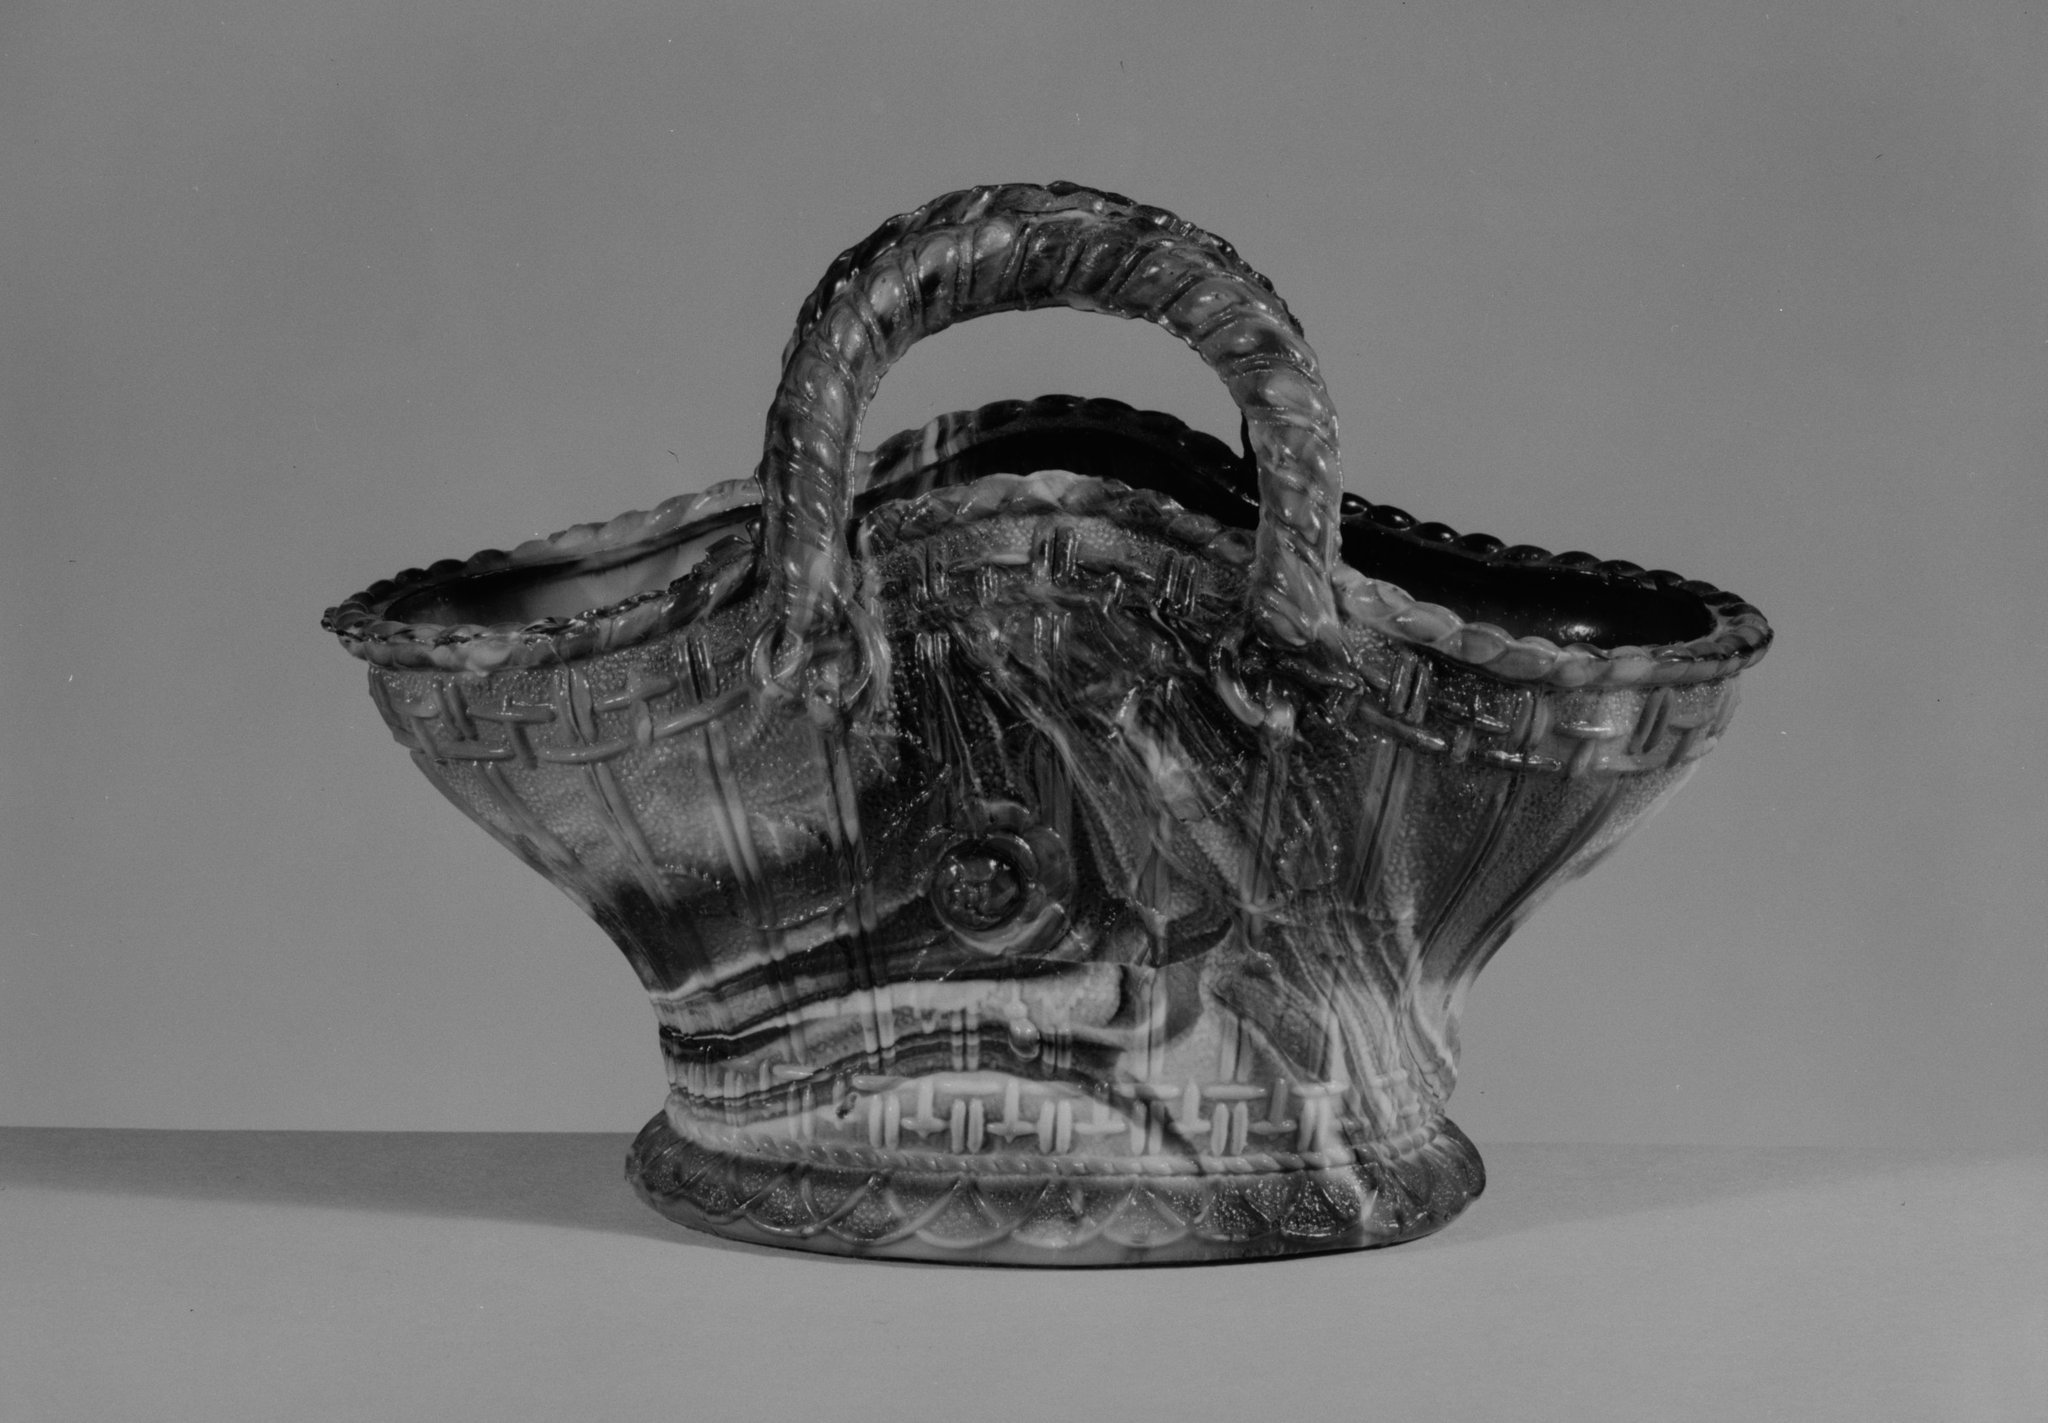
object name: basket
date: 1880-1890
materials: glass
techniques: pressed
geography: england